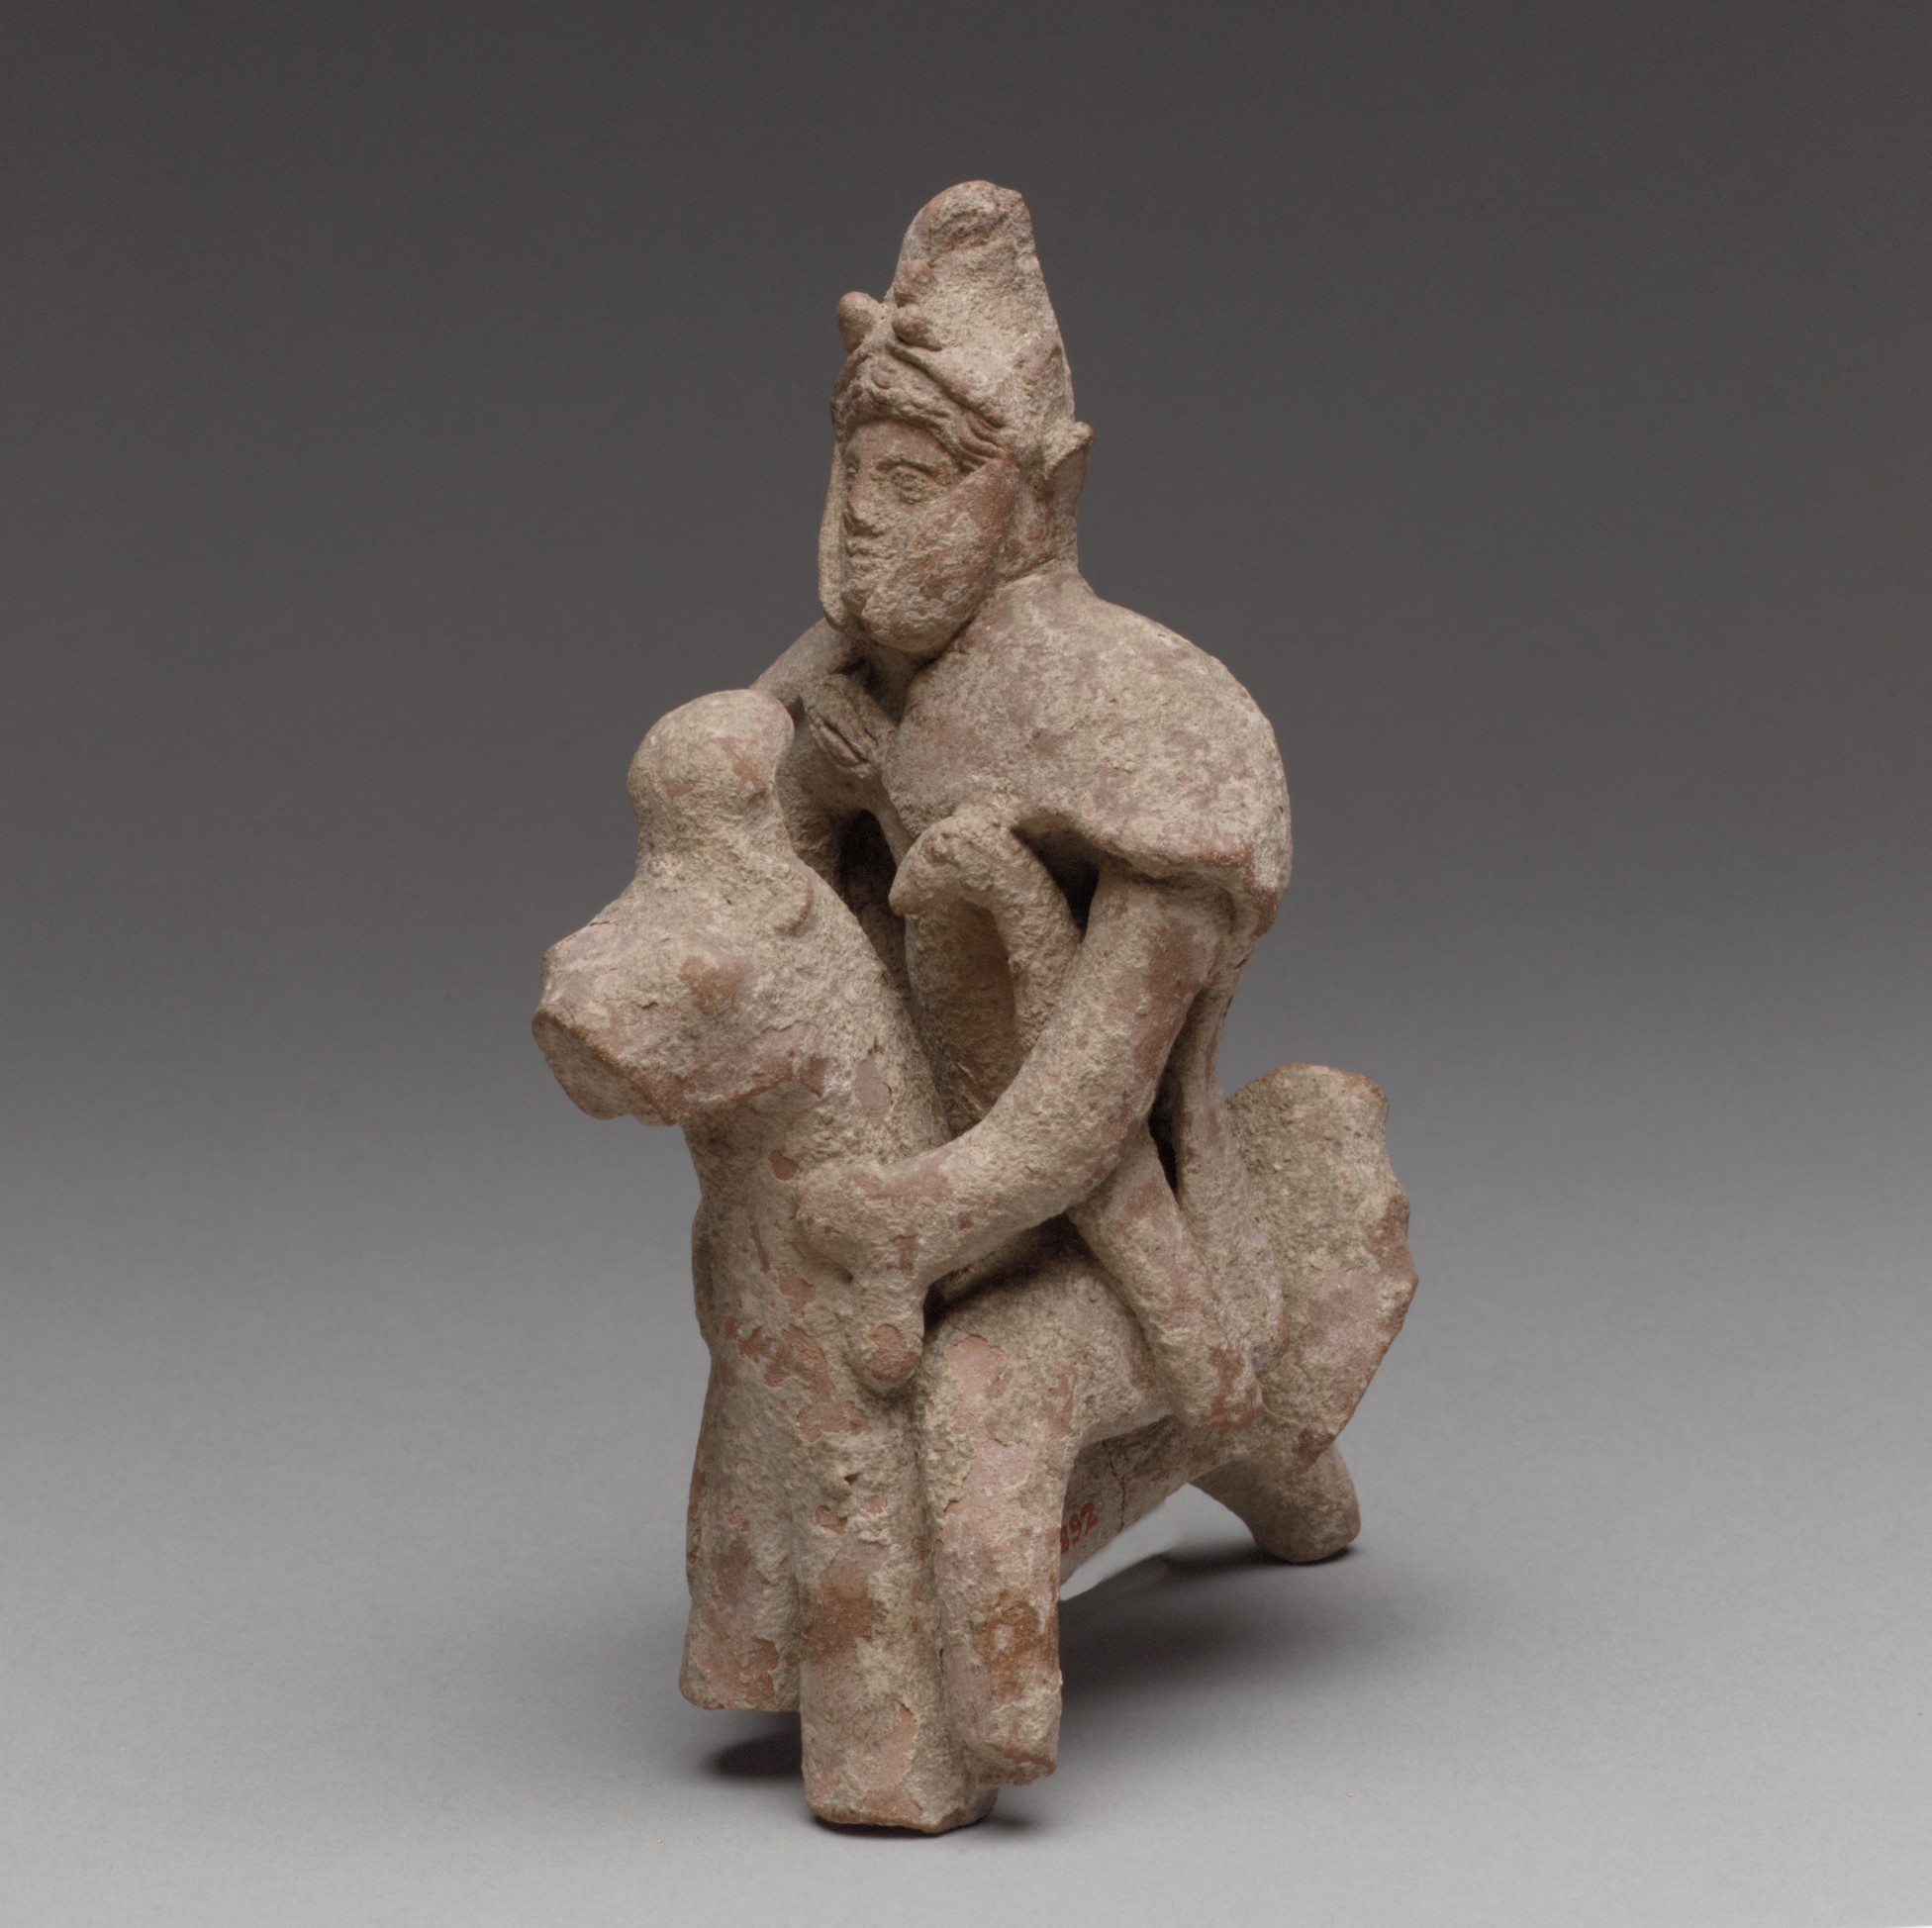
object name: statuette of a warrior on horse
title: Horse and rider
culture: cypriot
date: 400-201 BCE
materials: terracotta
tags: men,horses